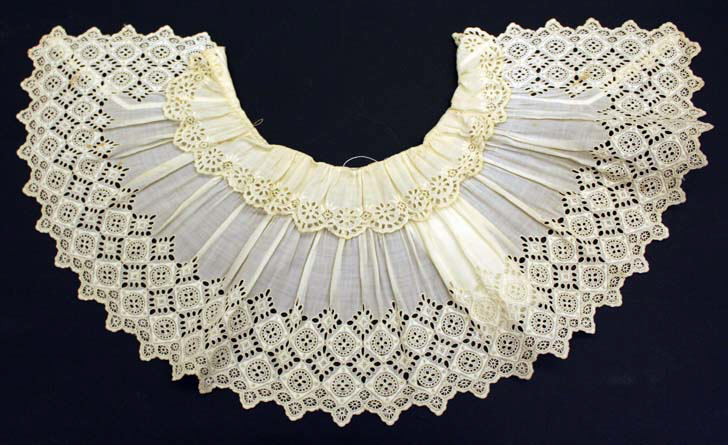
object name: collar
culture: american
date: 1700-1941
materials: cotton